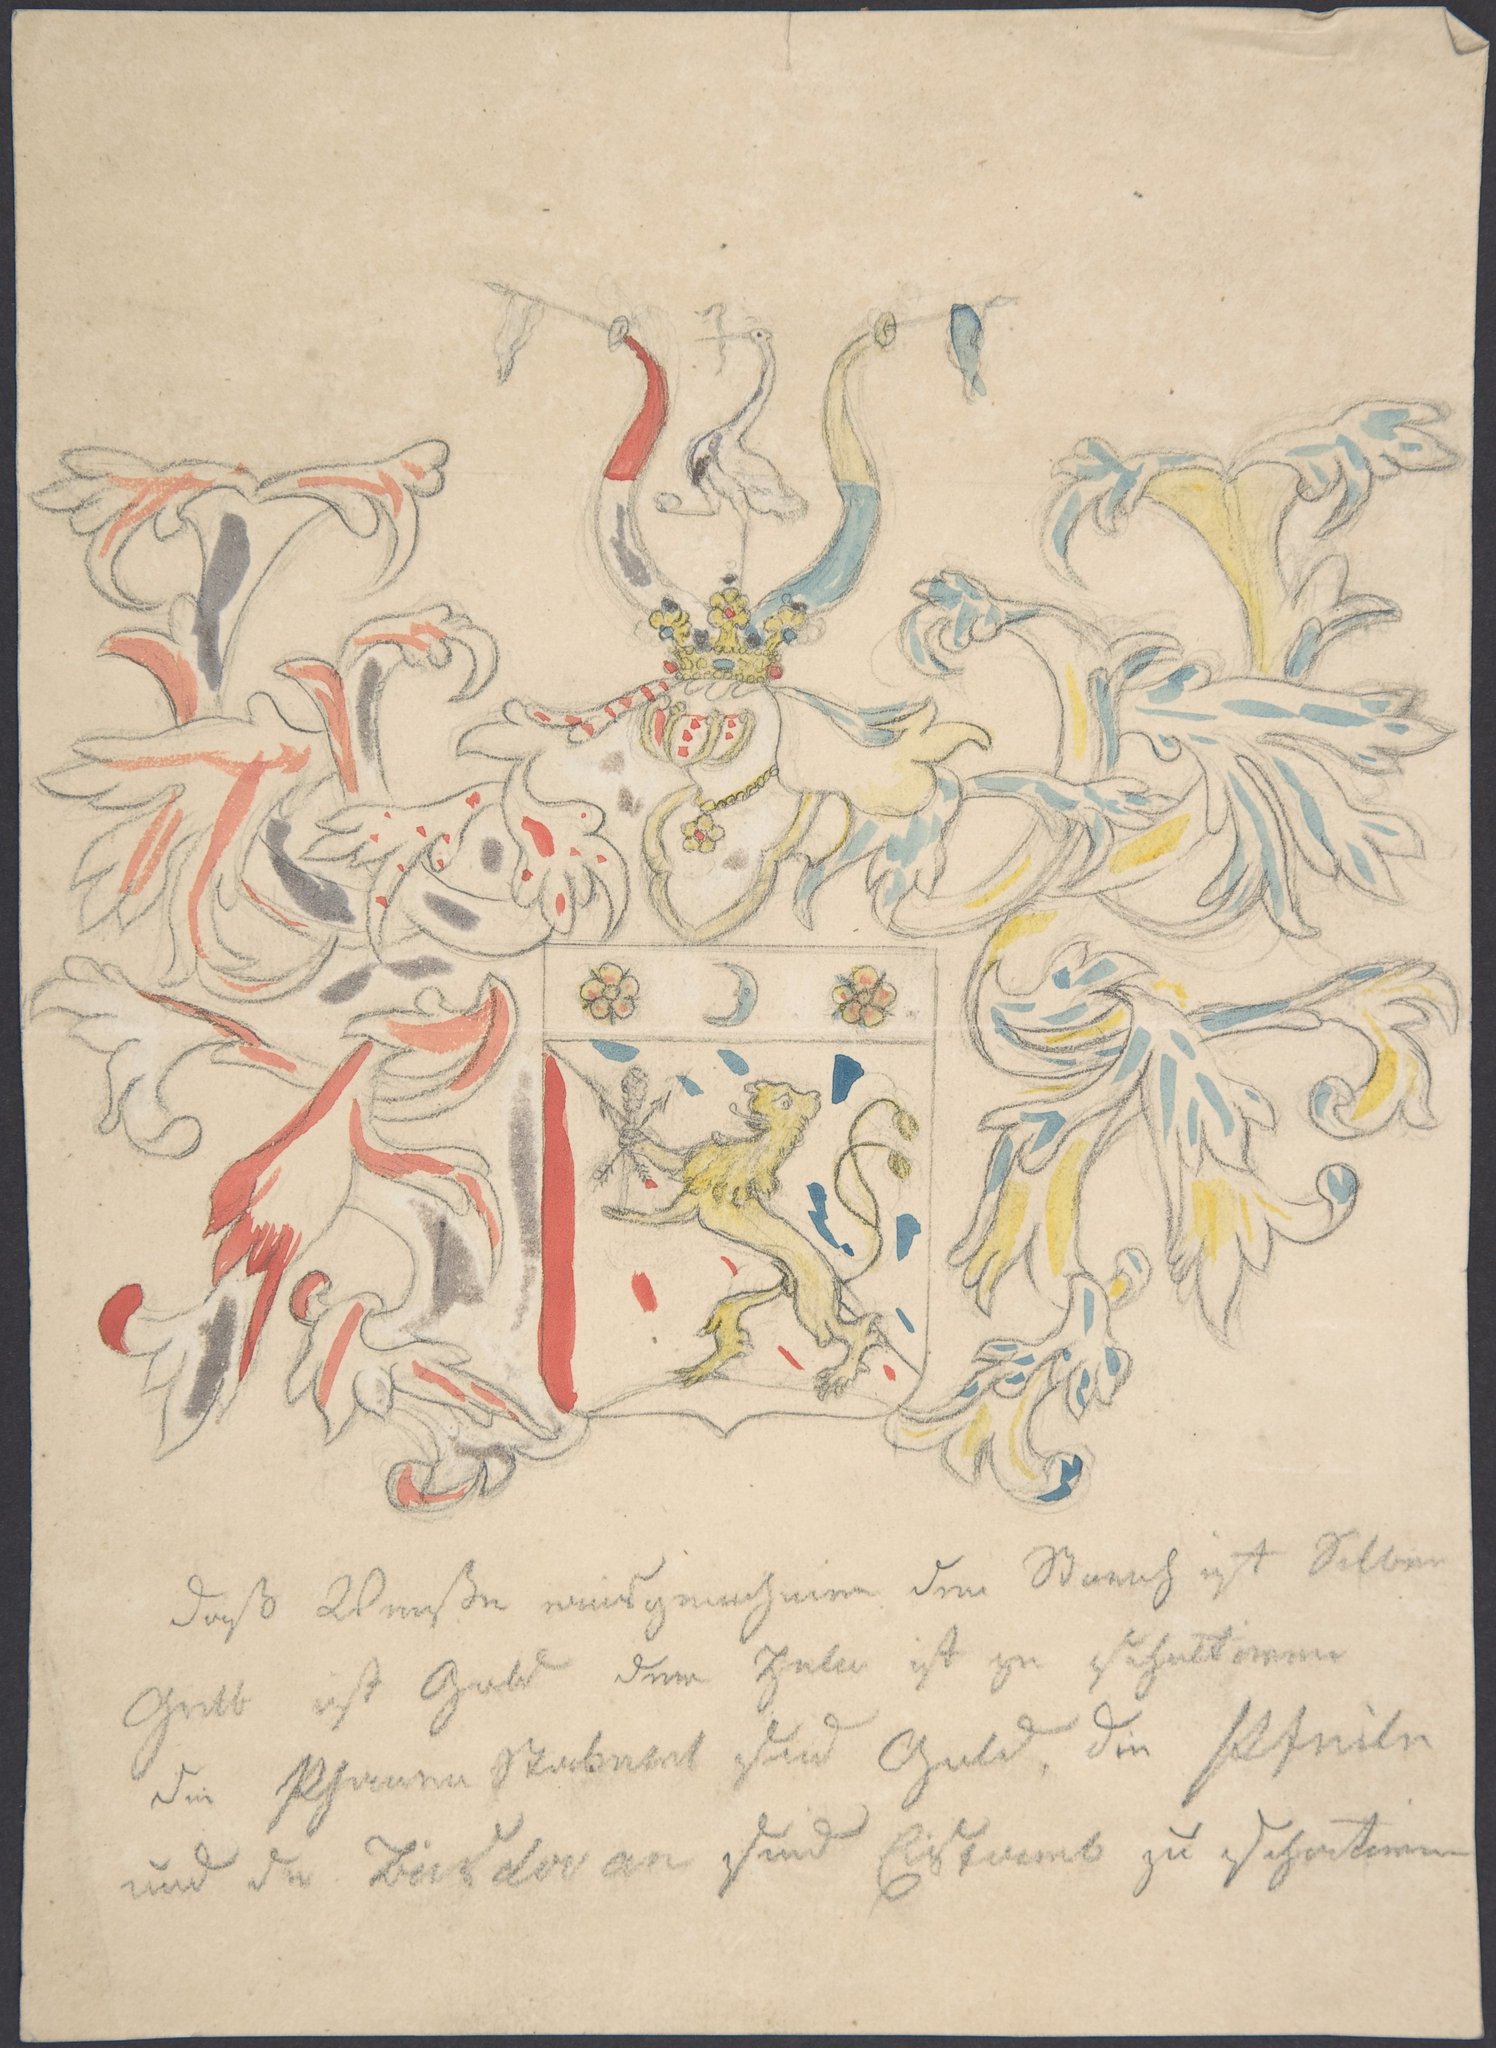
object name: drawing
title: Design for coat of arms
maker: anonymous, 18th century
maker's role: artist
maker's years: 1700-1800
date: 1701-1800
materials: graphite, watercolor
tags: birds,coat of arms